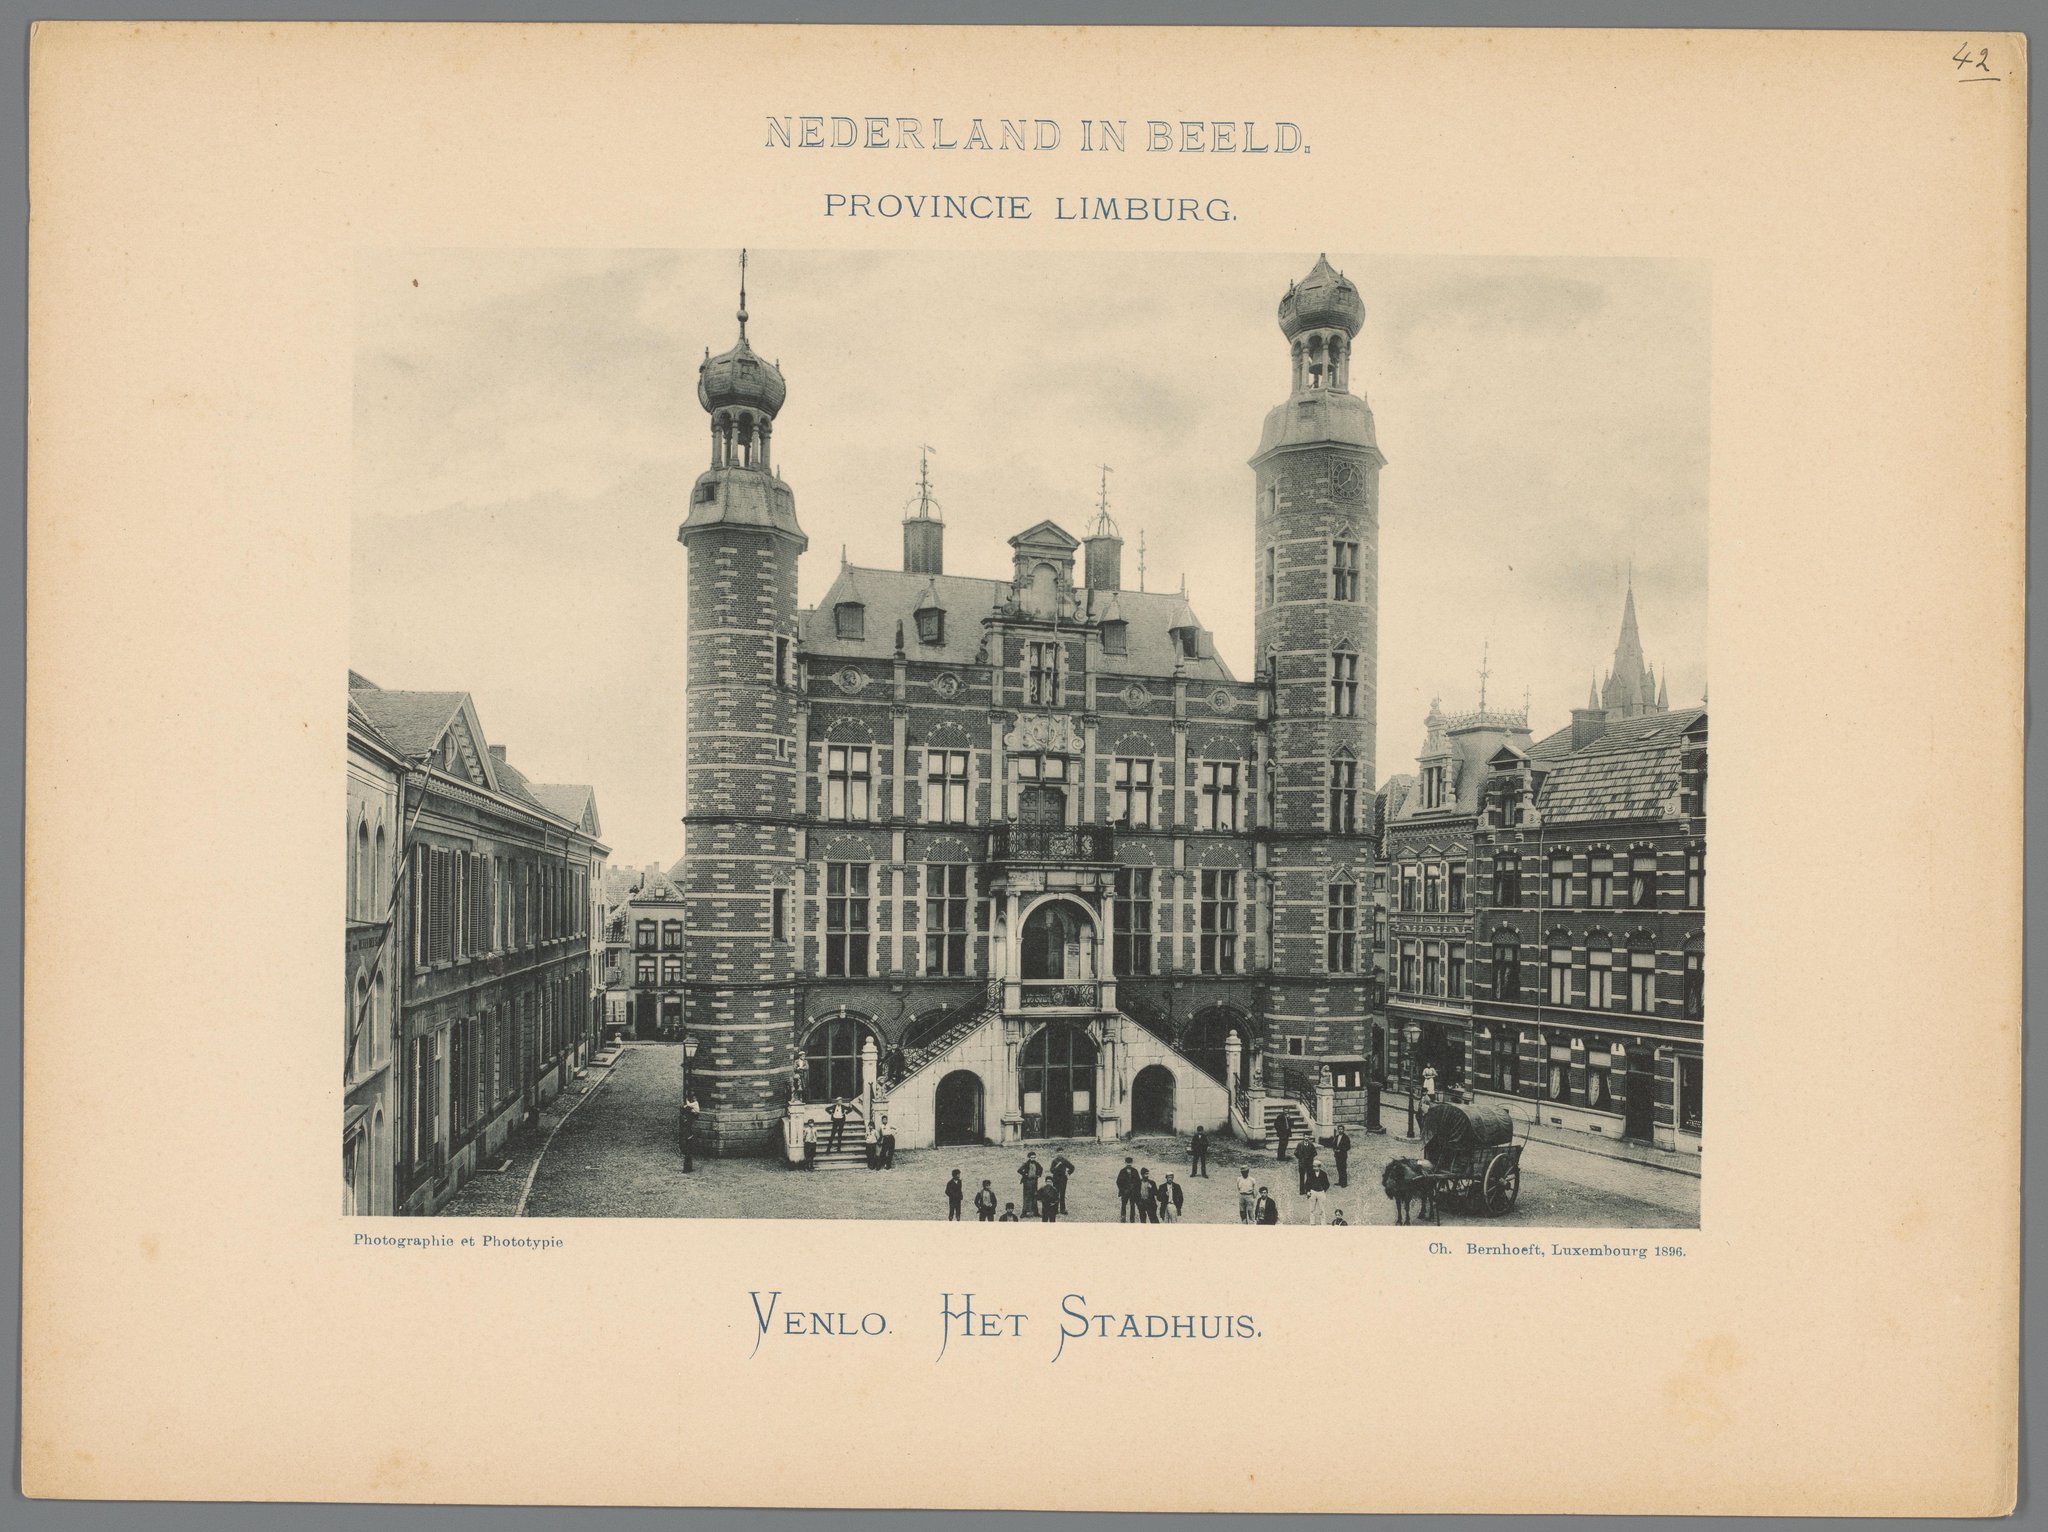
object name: photomechanical print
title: Nederland in beeld. Provincie Noord-Brabant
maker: charles bernhoeft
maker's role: publisher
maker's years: 1859-1933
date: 1896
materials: paper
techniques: photograph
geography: venlo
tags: townhall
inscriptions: number: ‘42.’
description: Deze prent maakt deel uit van een omslag met 43 lichtdrukken op 43 bladen.